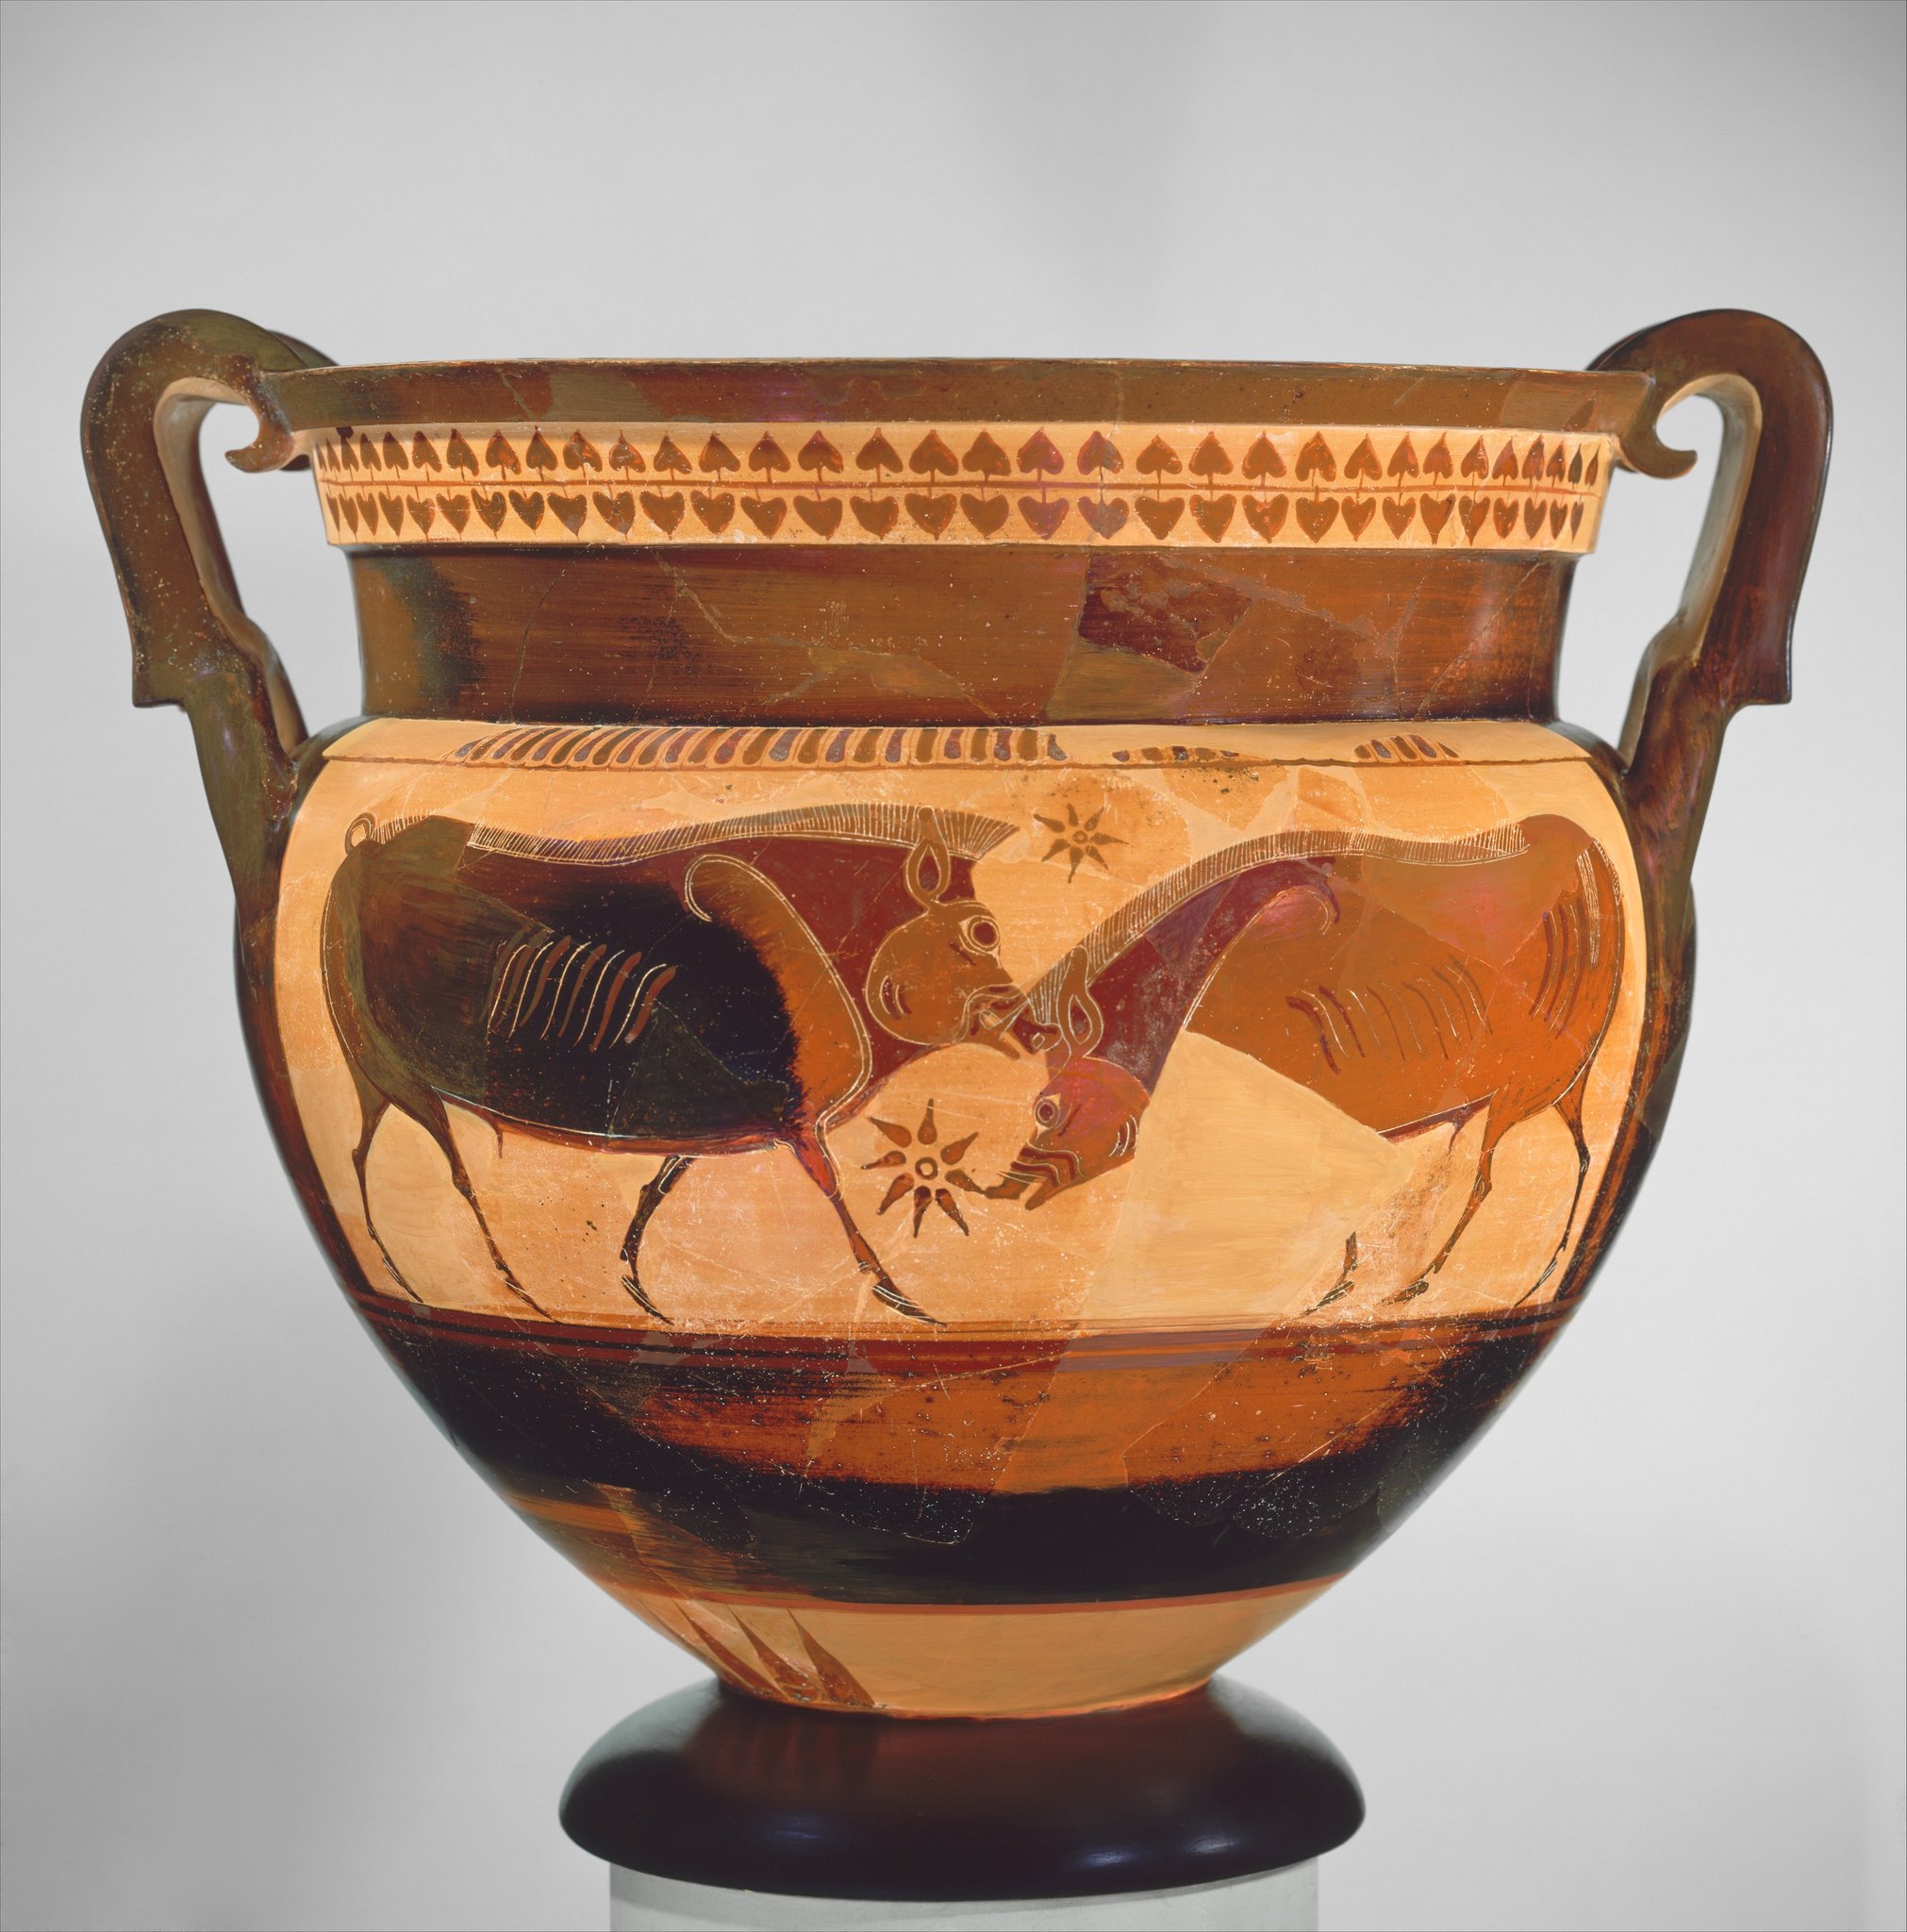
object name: krater chalcidian shape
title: Terracotta volute-krater (vase for mixing wine and water)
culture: greek, attic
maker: sophilos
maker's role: artist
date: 600-568 BCE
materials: terracotta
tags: boars